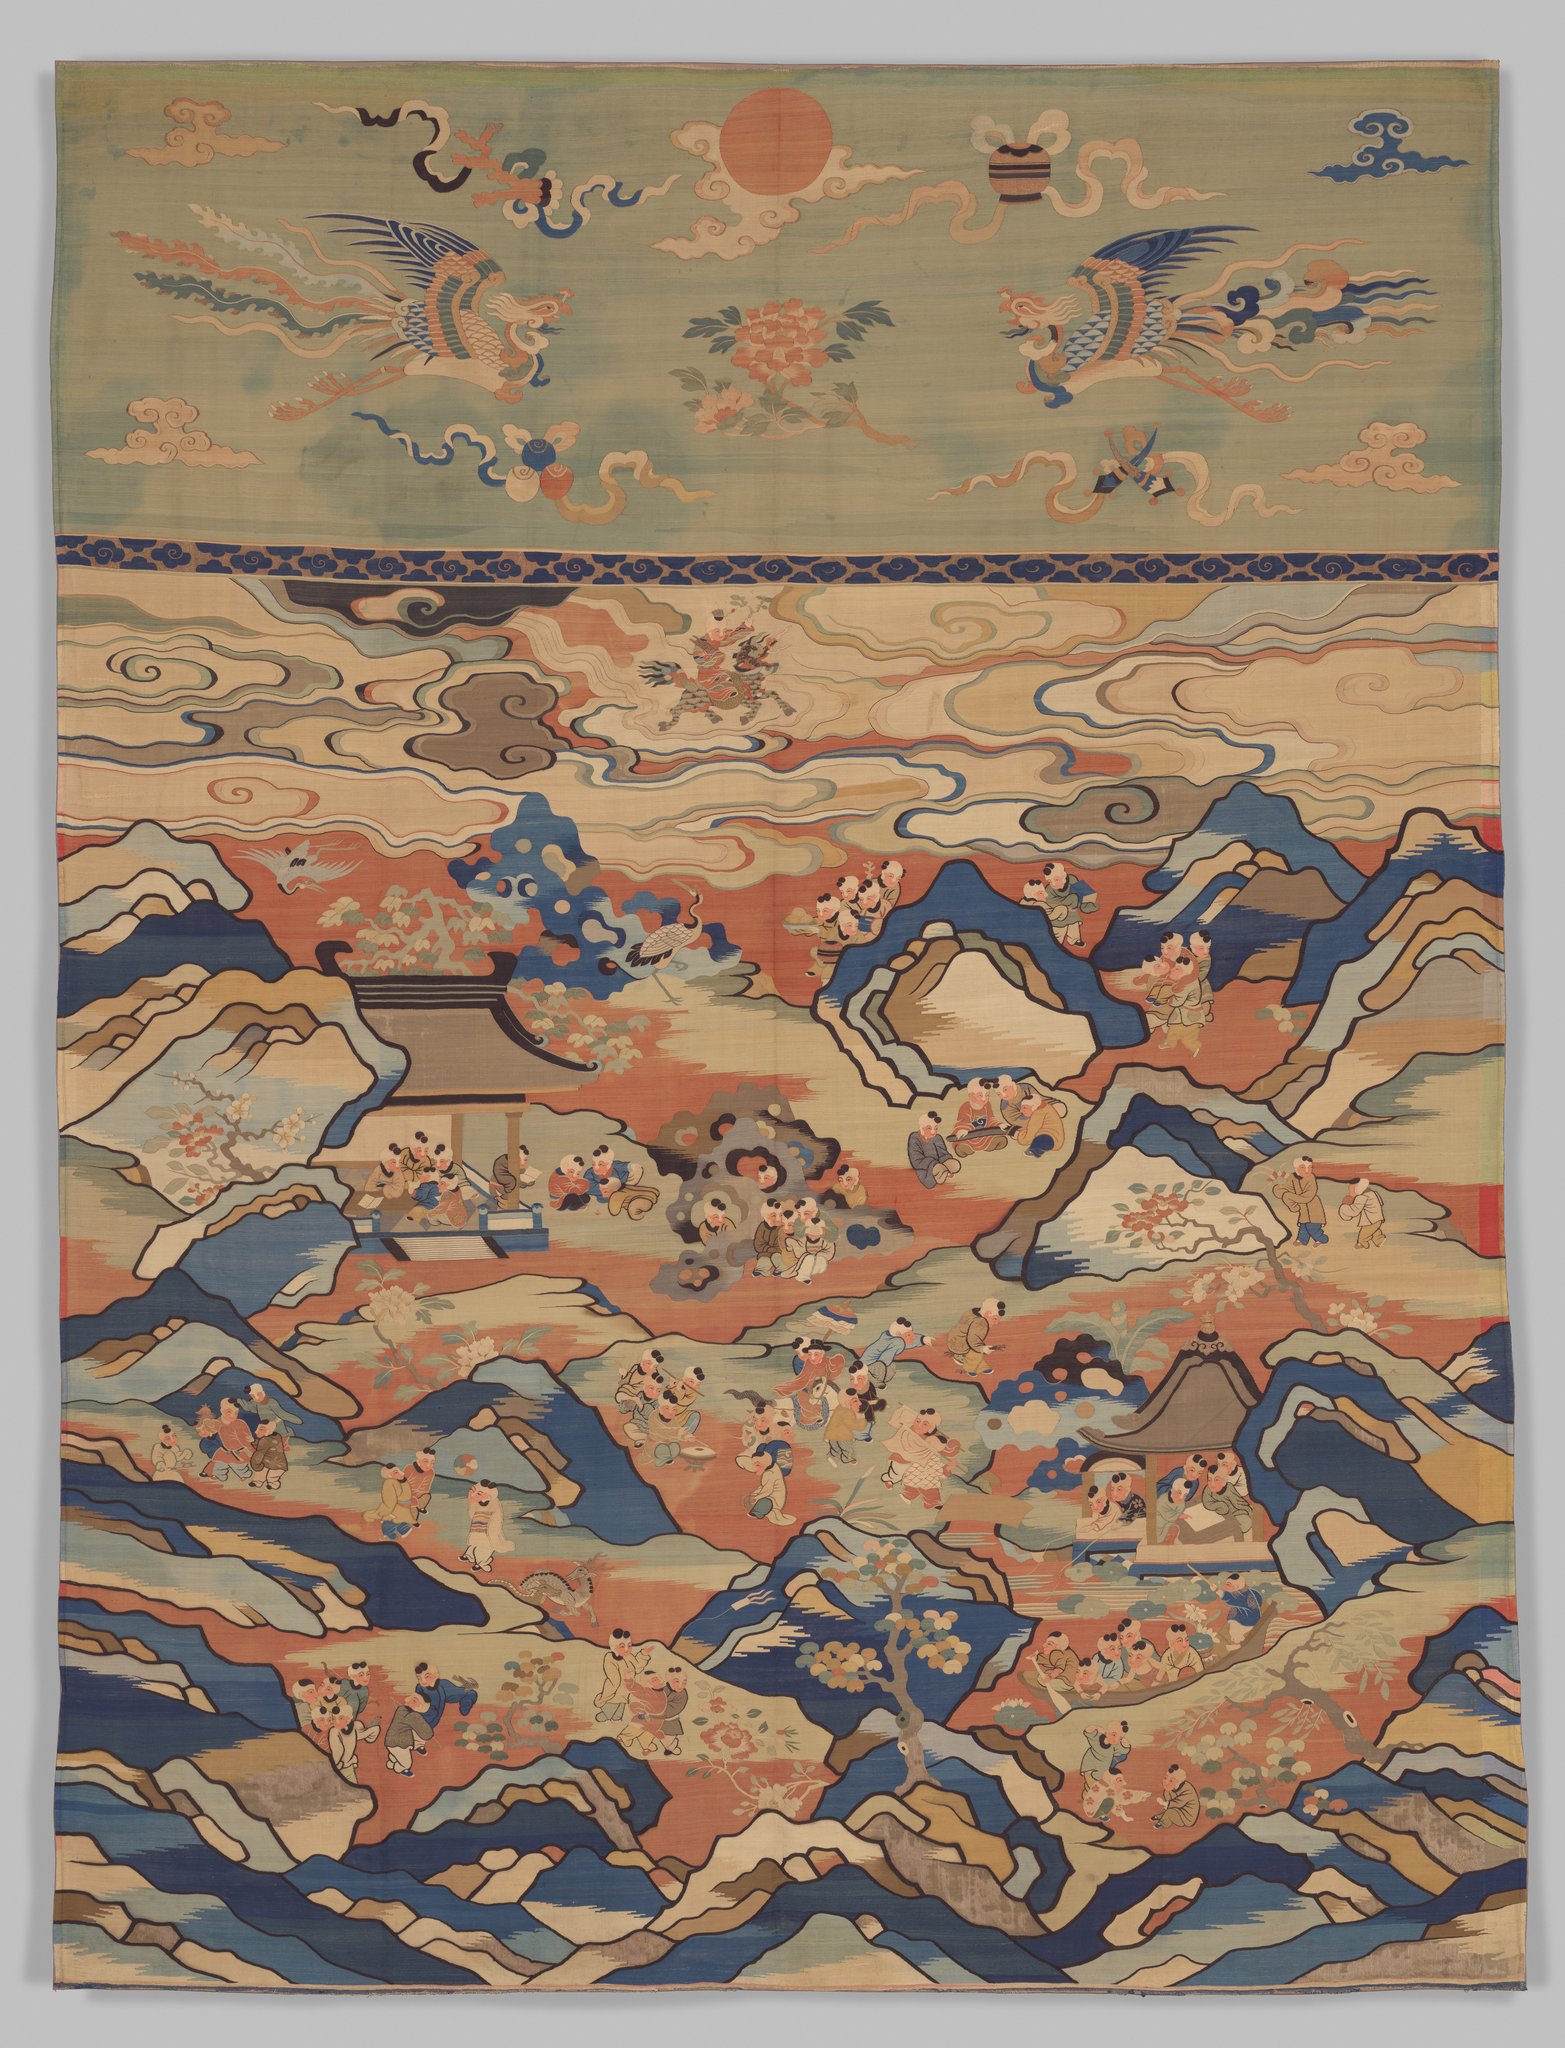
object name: panel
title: Panel with boys at play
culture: chinese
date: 1601-1700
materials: feather, metal thread, silk, thread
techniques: tapestry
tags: cranes,boys,playing,flowers